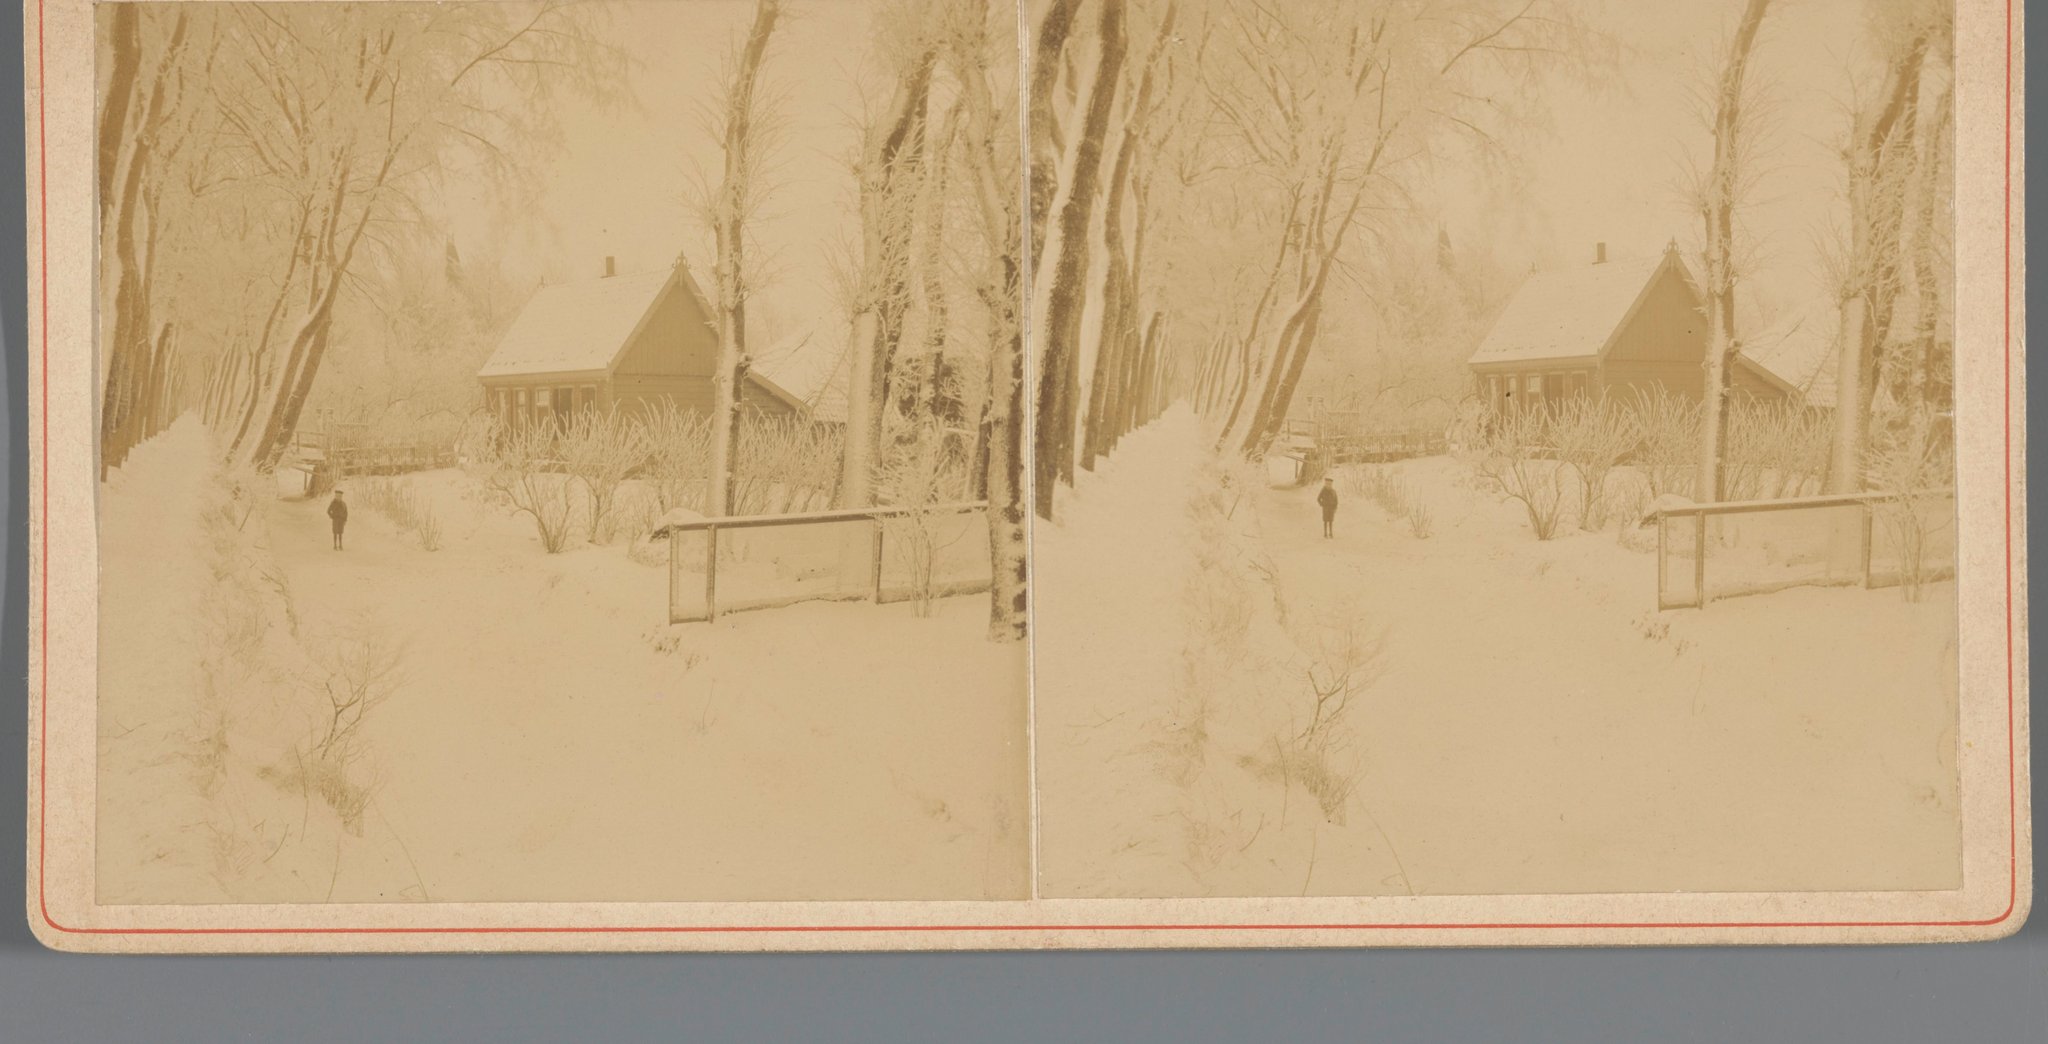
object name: stereograph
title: Haarlemmerweg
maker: Anonymous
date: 1900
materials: cardboard, photographic support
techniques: gelatin silver print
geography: amsterdam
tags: haarlemmerweg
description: De Haarlemmerweg te Amsterdam, in de sneeuw. Onderdeel van een groep van 5 foto's en 19 stereofoto's gemaakt door een onbekende amateurfotograaf rond 1900 in Amsterdam, de Ardennen en Denemarken.